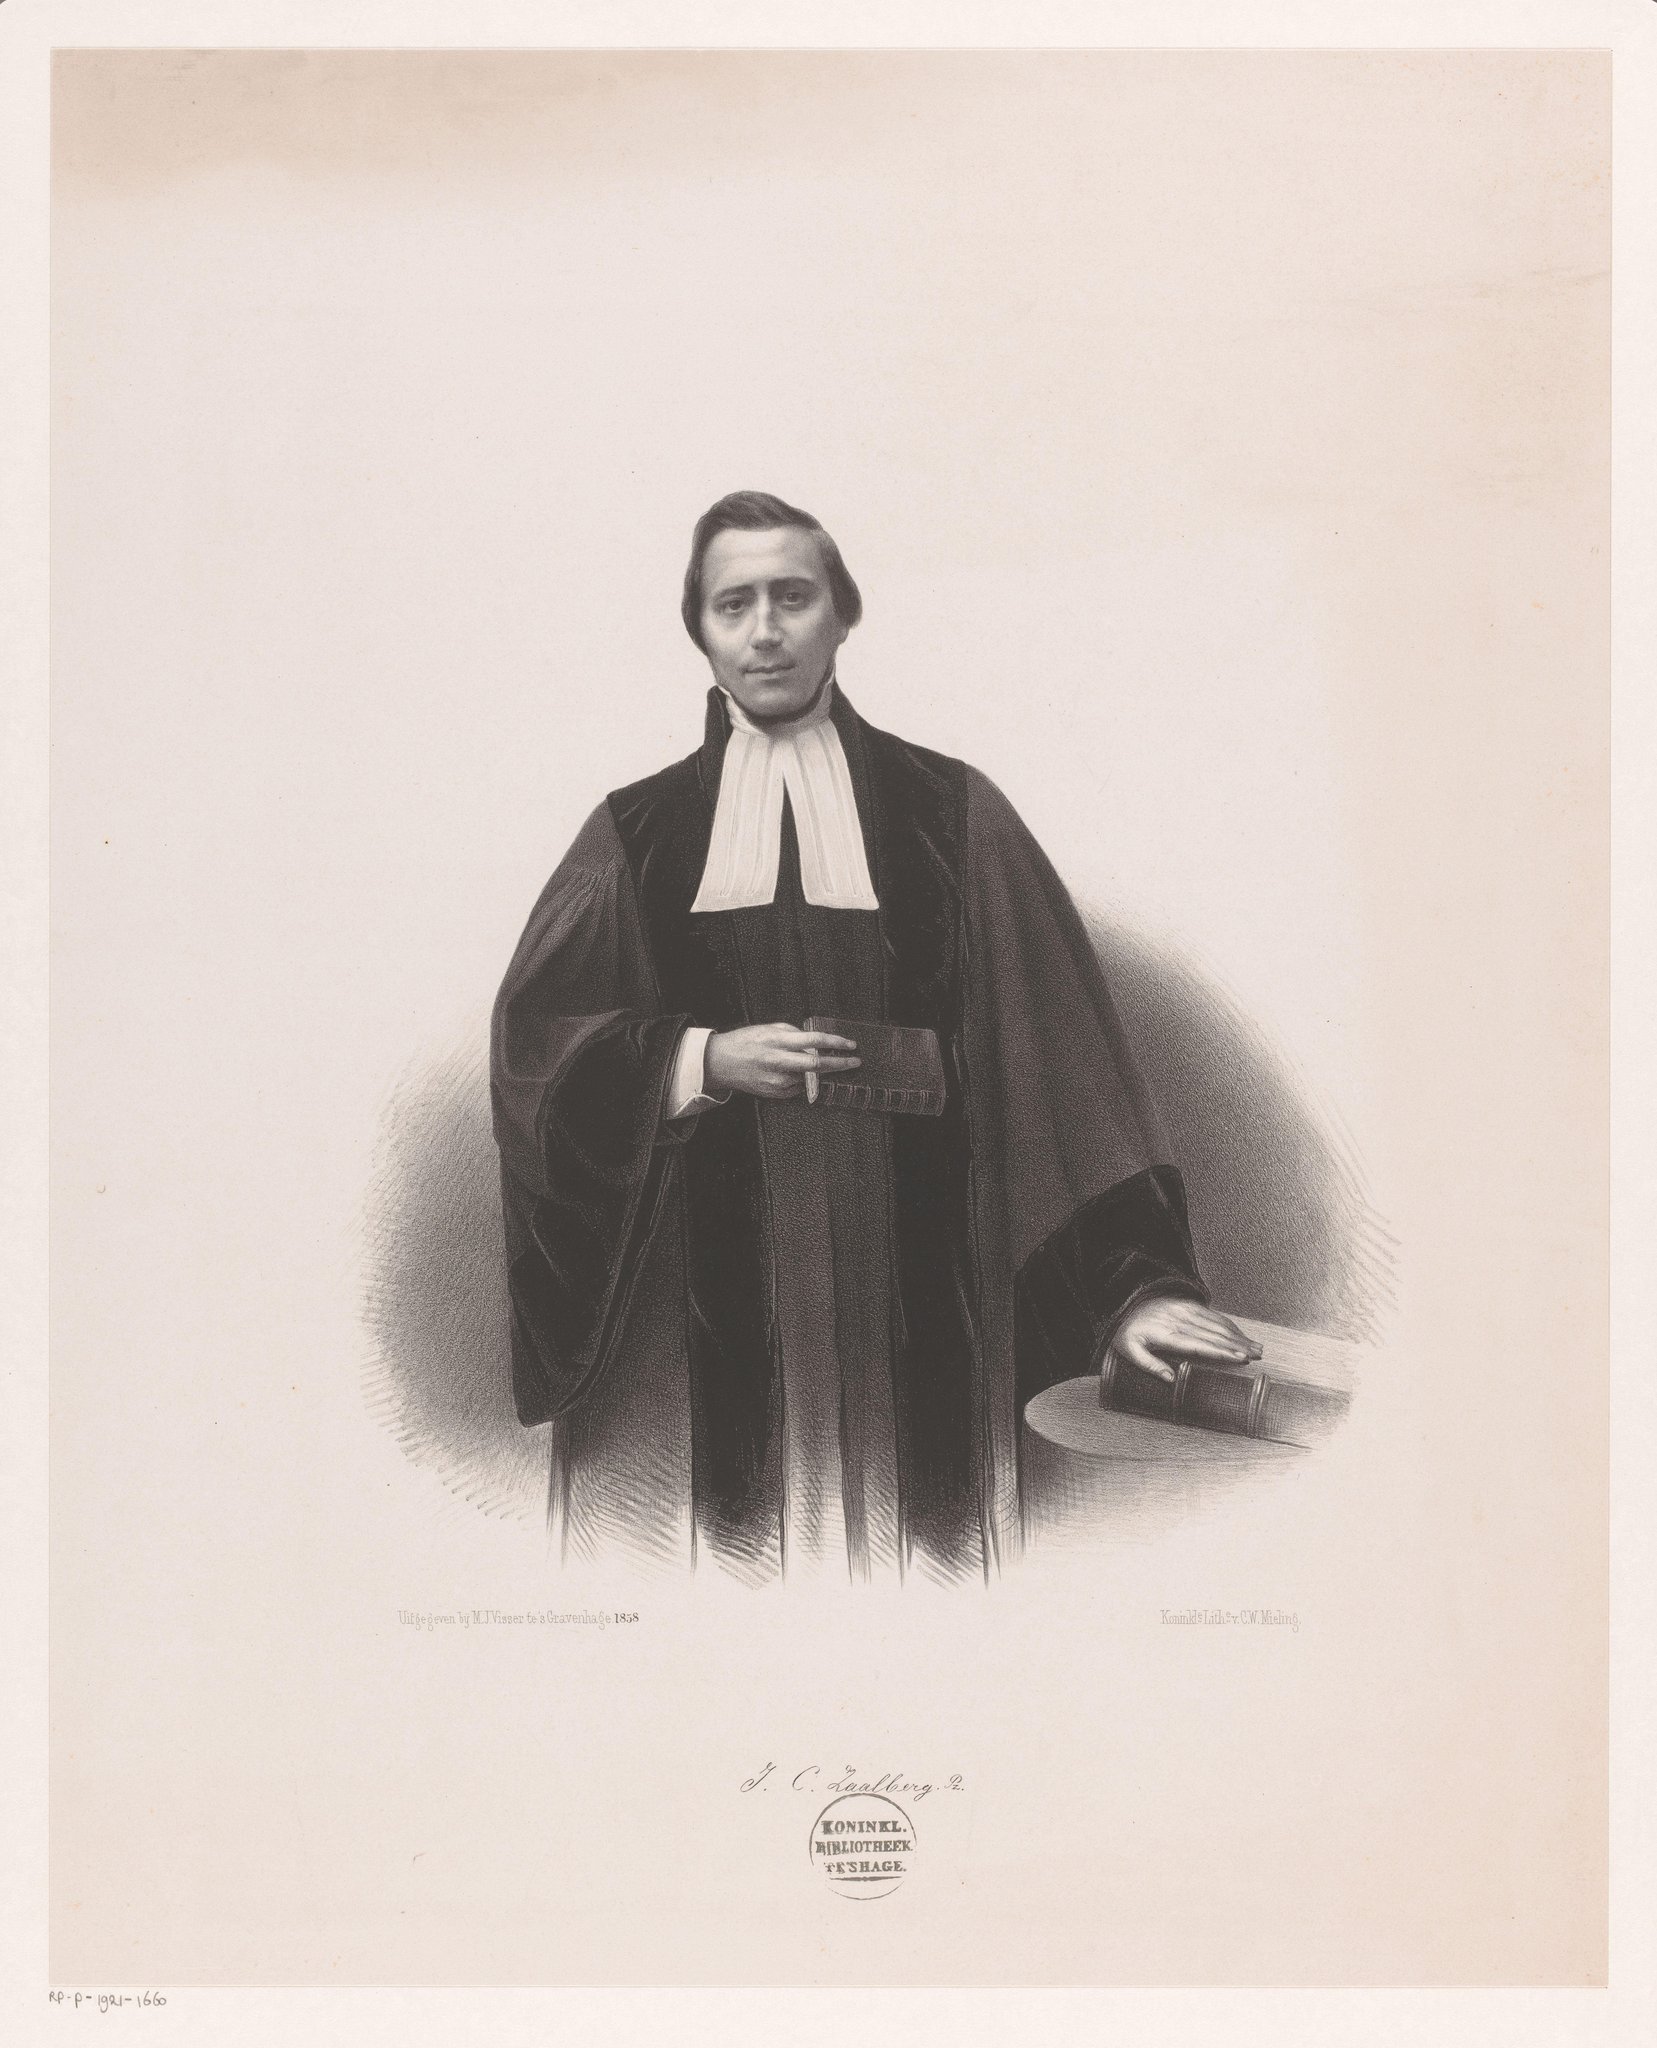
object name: print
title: Portret van Johannes Cornelis Zaalberg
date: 1858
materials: paper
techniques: lithograph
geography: the hague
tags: book, historical persons (+ three-quarter length portrait)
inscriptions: collector's mark: Lugt 2233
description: De geportretteerde draagt een toga met bef. Zijn linkerhand rust op een boek, in zijn rechterhand heeft hij een tweede boek. Onder het portret zijn signatuur.